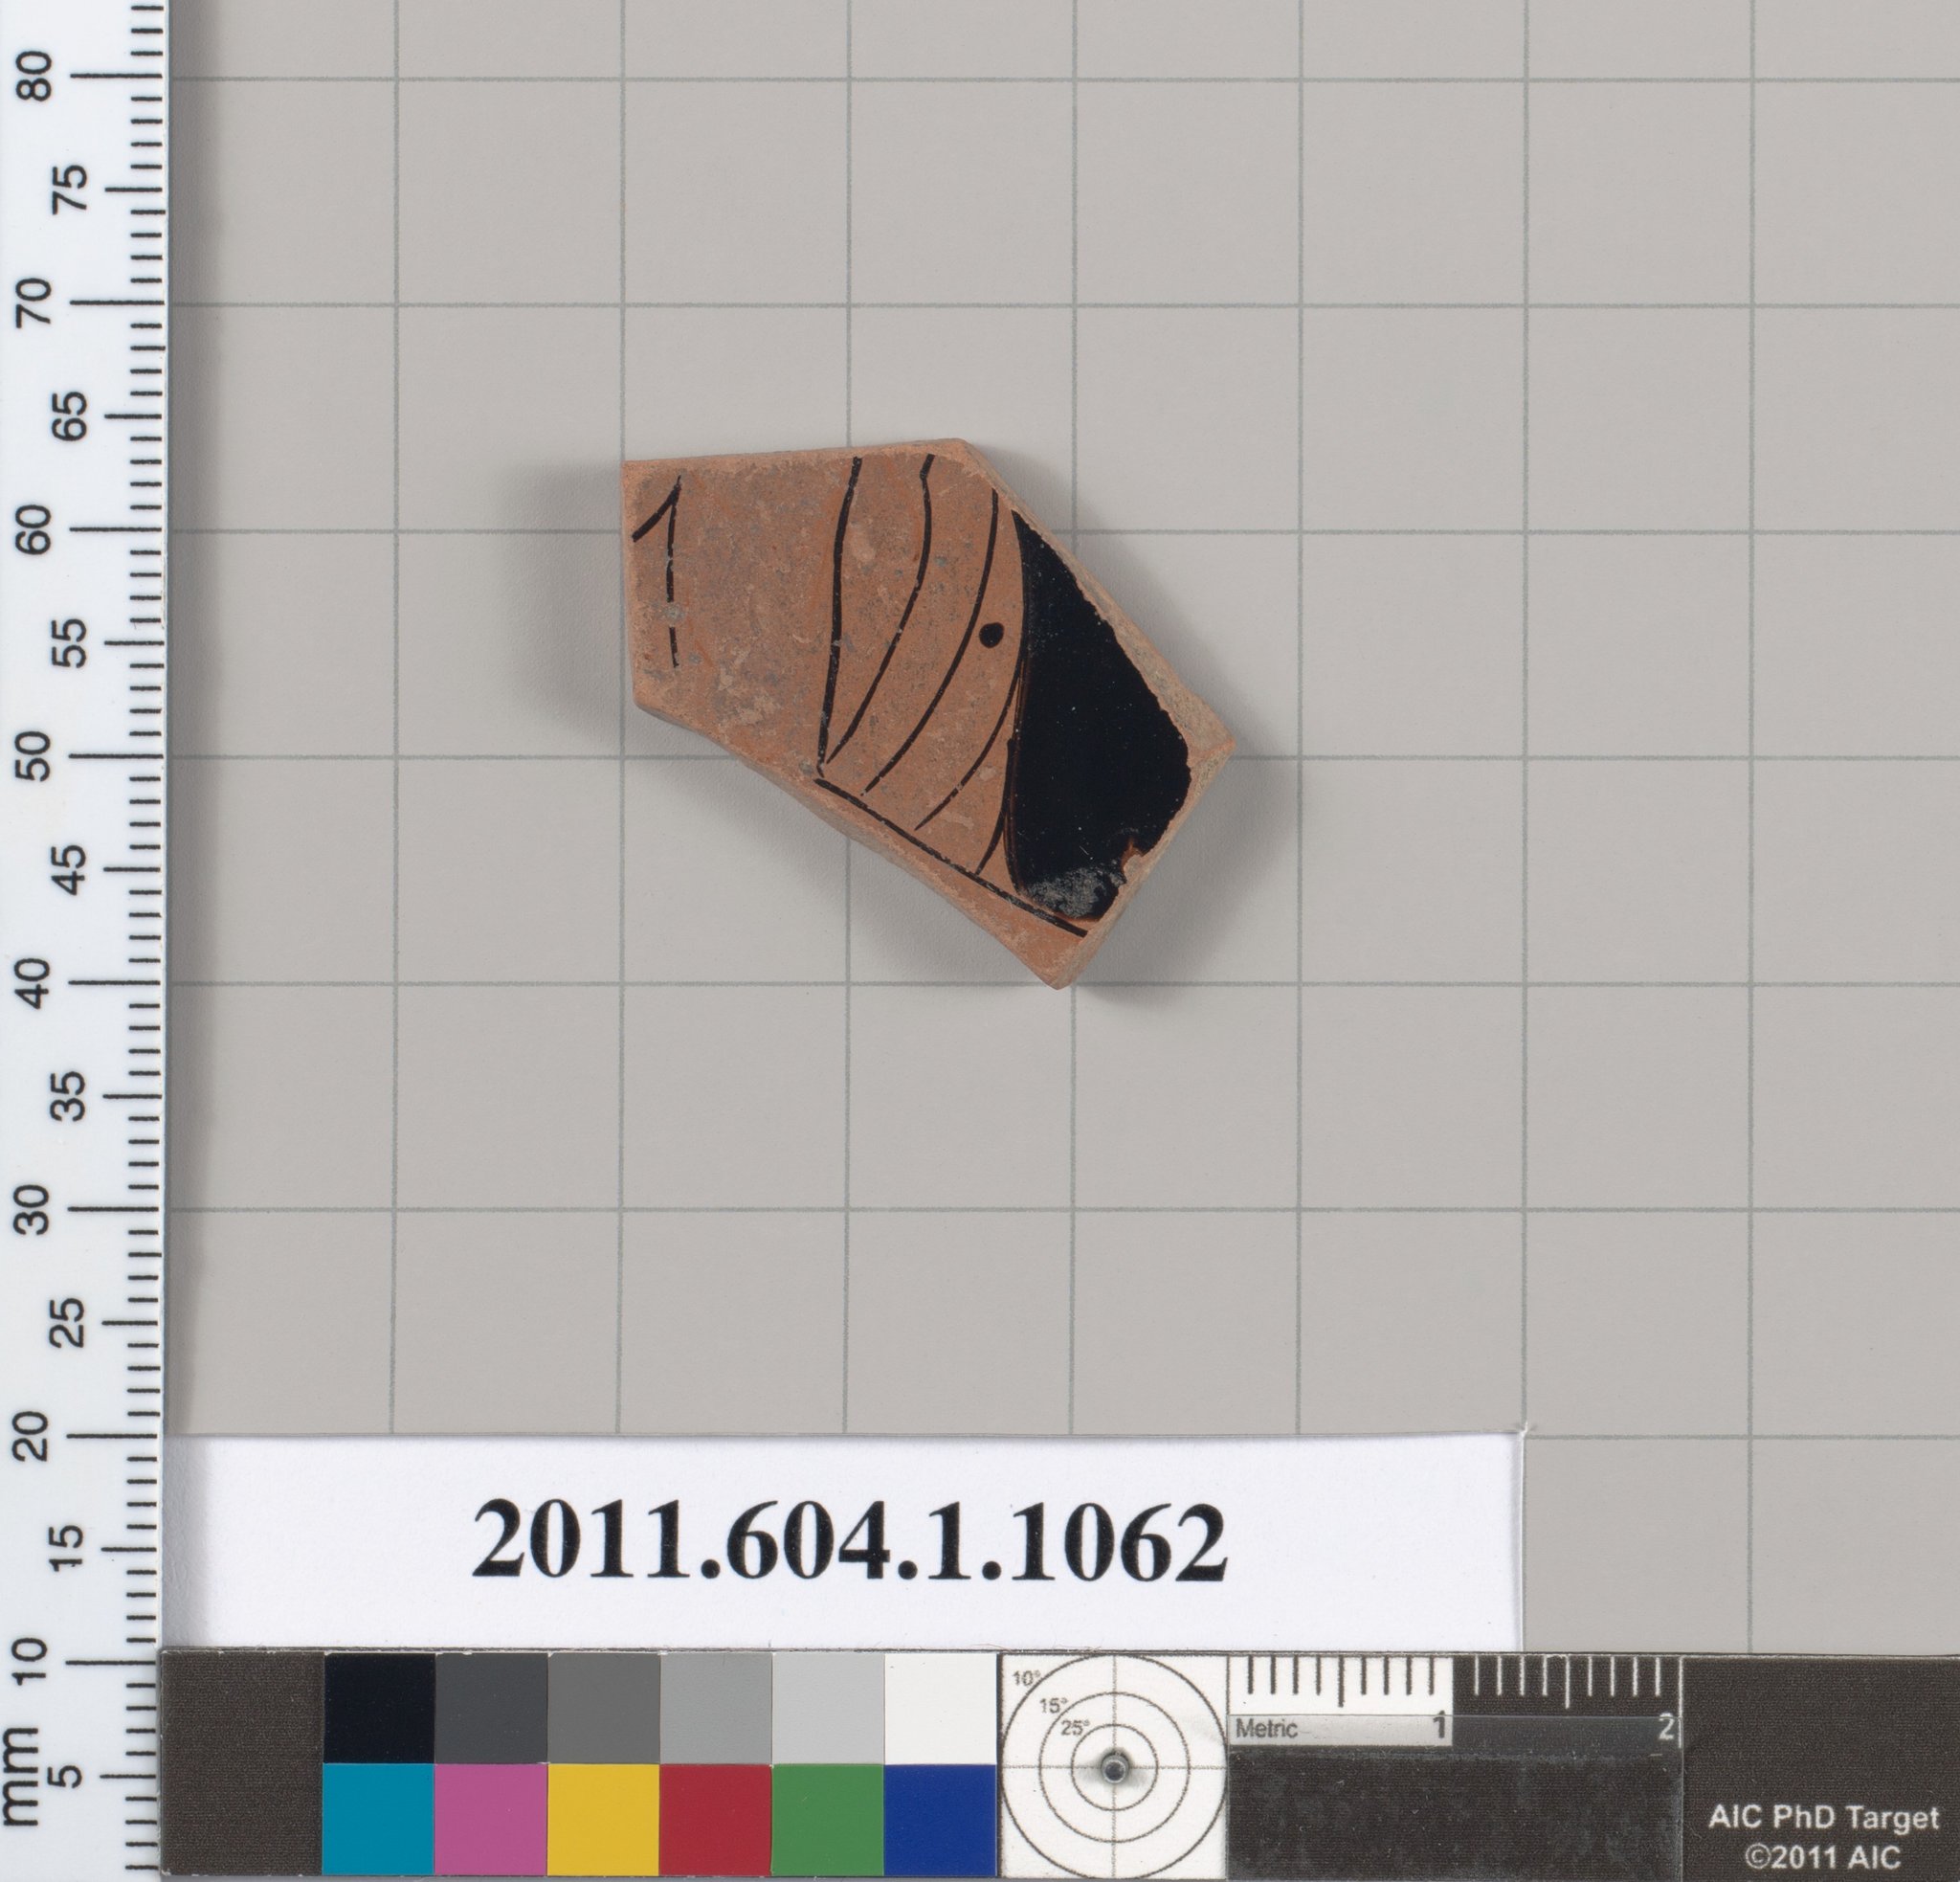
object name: kylix fragment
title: Terracotta fragment of a kylix (drinking cup)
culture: greek, attic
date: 490-480 BCE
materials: terracotta